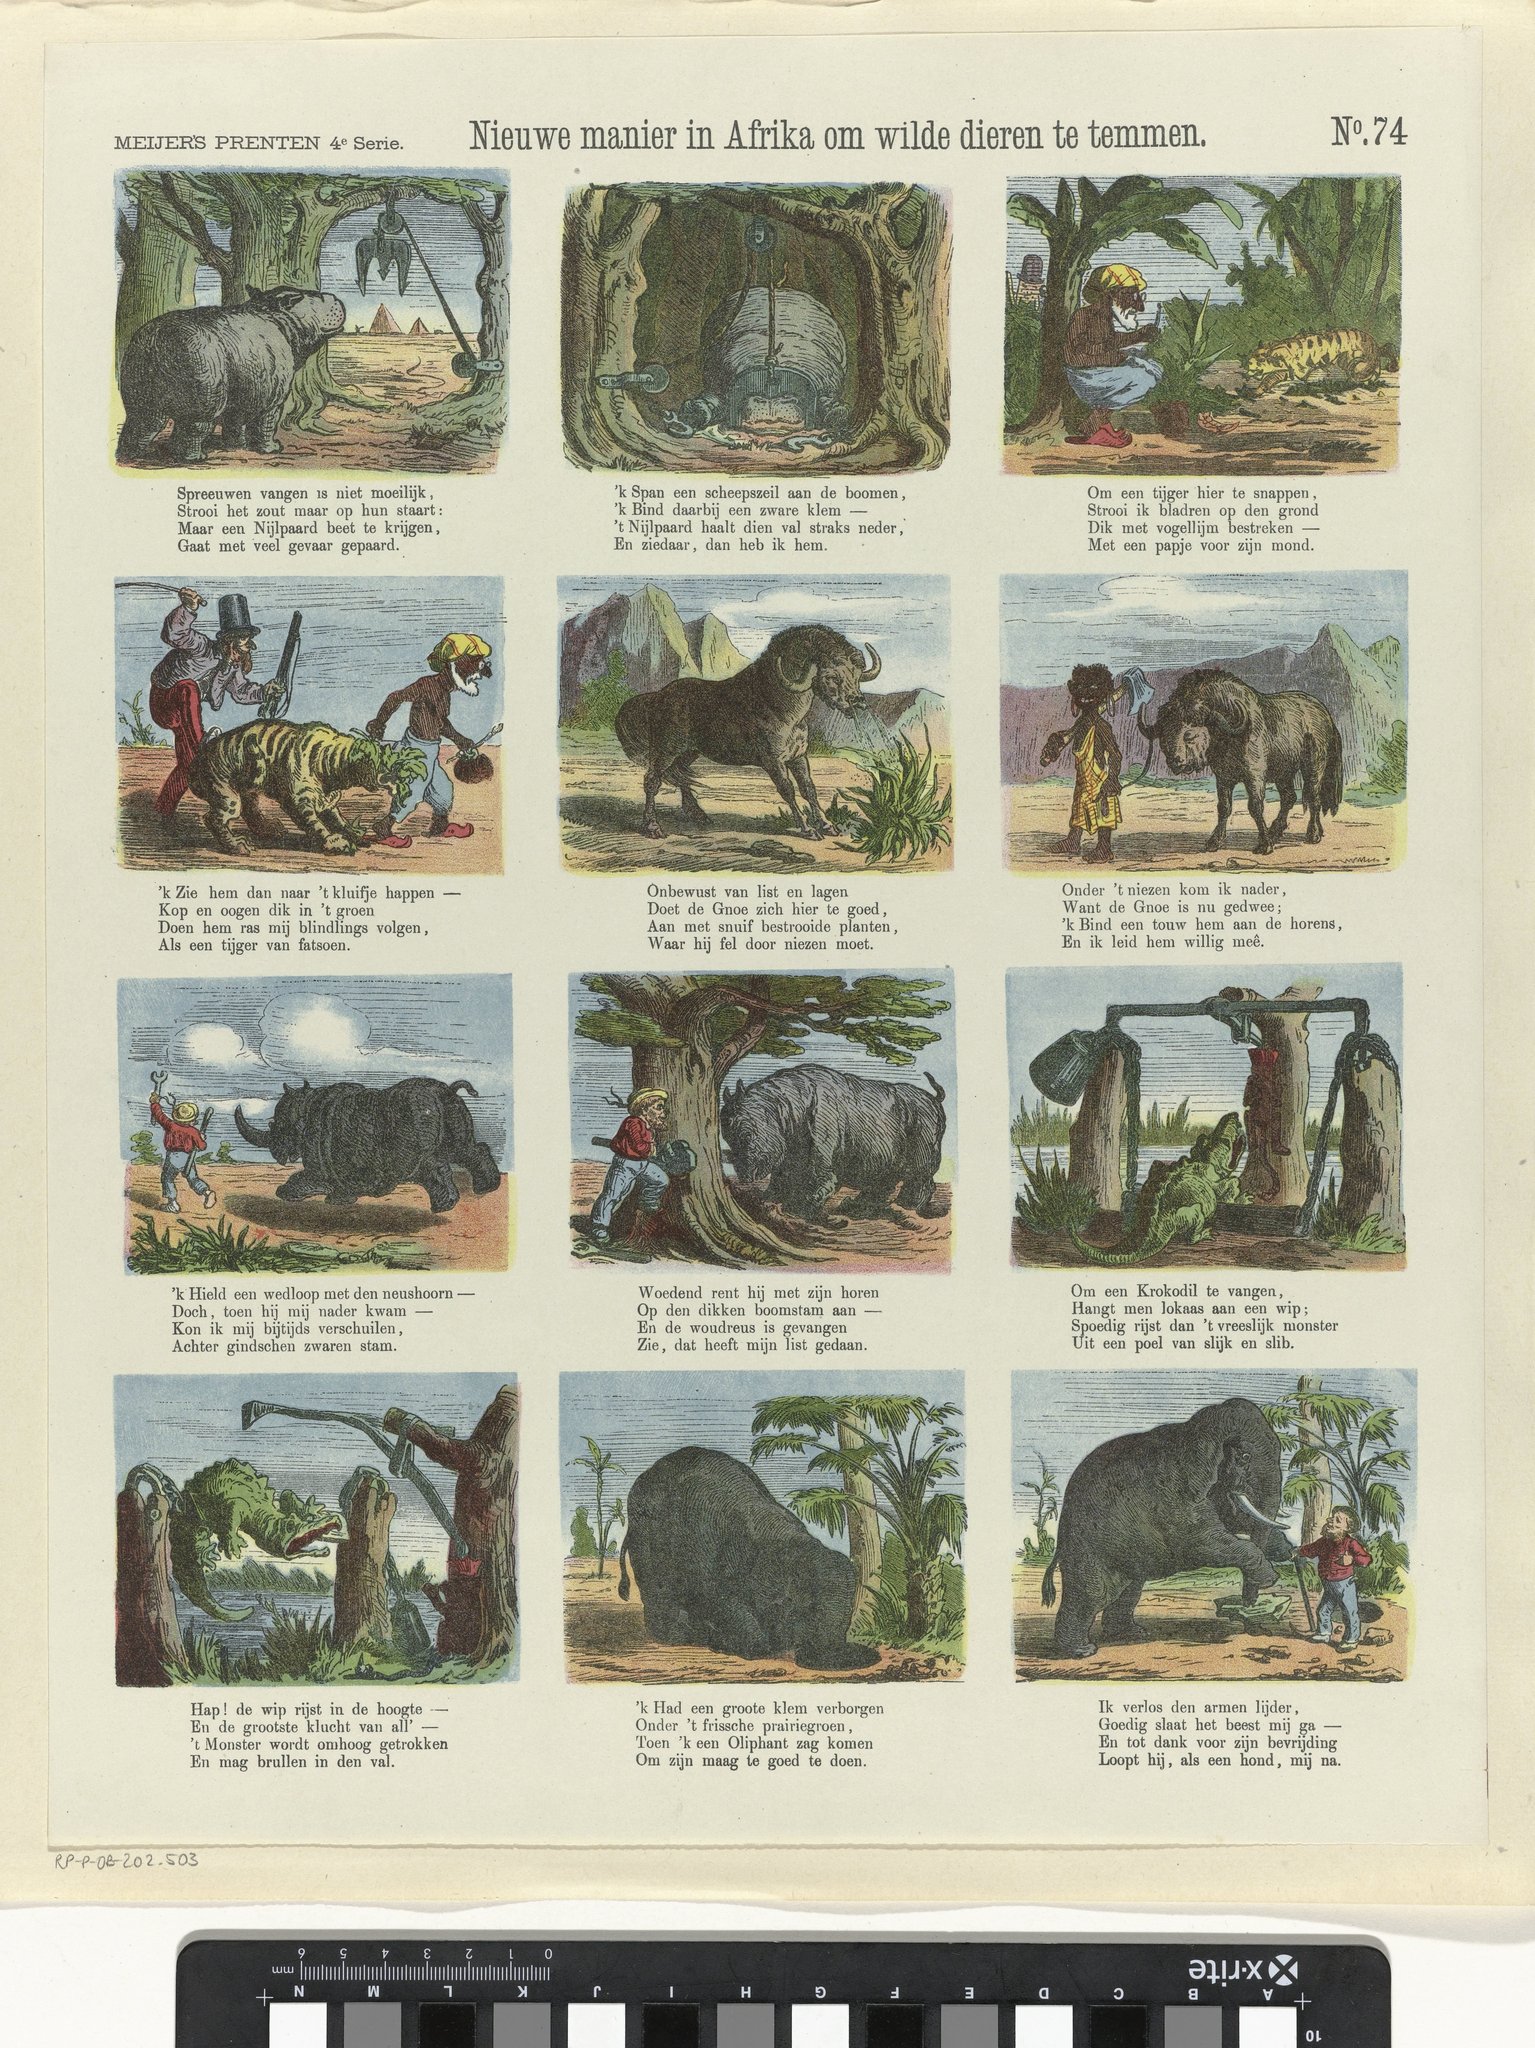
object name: popular print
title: Meijer's prenten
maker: Anonymous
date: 1881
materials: paper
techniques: lithograph, letterpress printing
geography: amsterdam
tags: taming and training of animals, animals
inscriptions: collector's mark: Lugt 2760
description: Blad met 12 voorstellingen over het temmen van wilde dieren in Afrika. Onder elke afbeelding een vierregelig vers. Genummerd rechtsboven: No. 74.